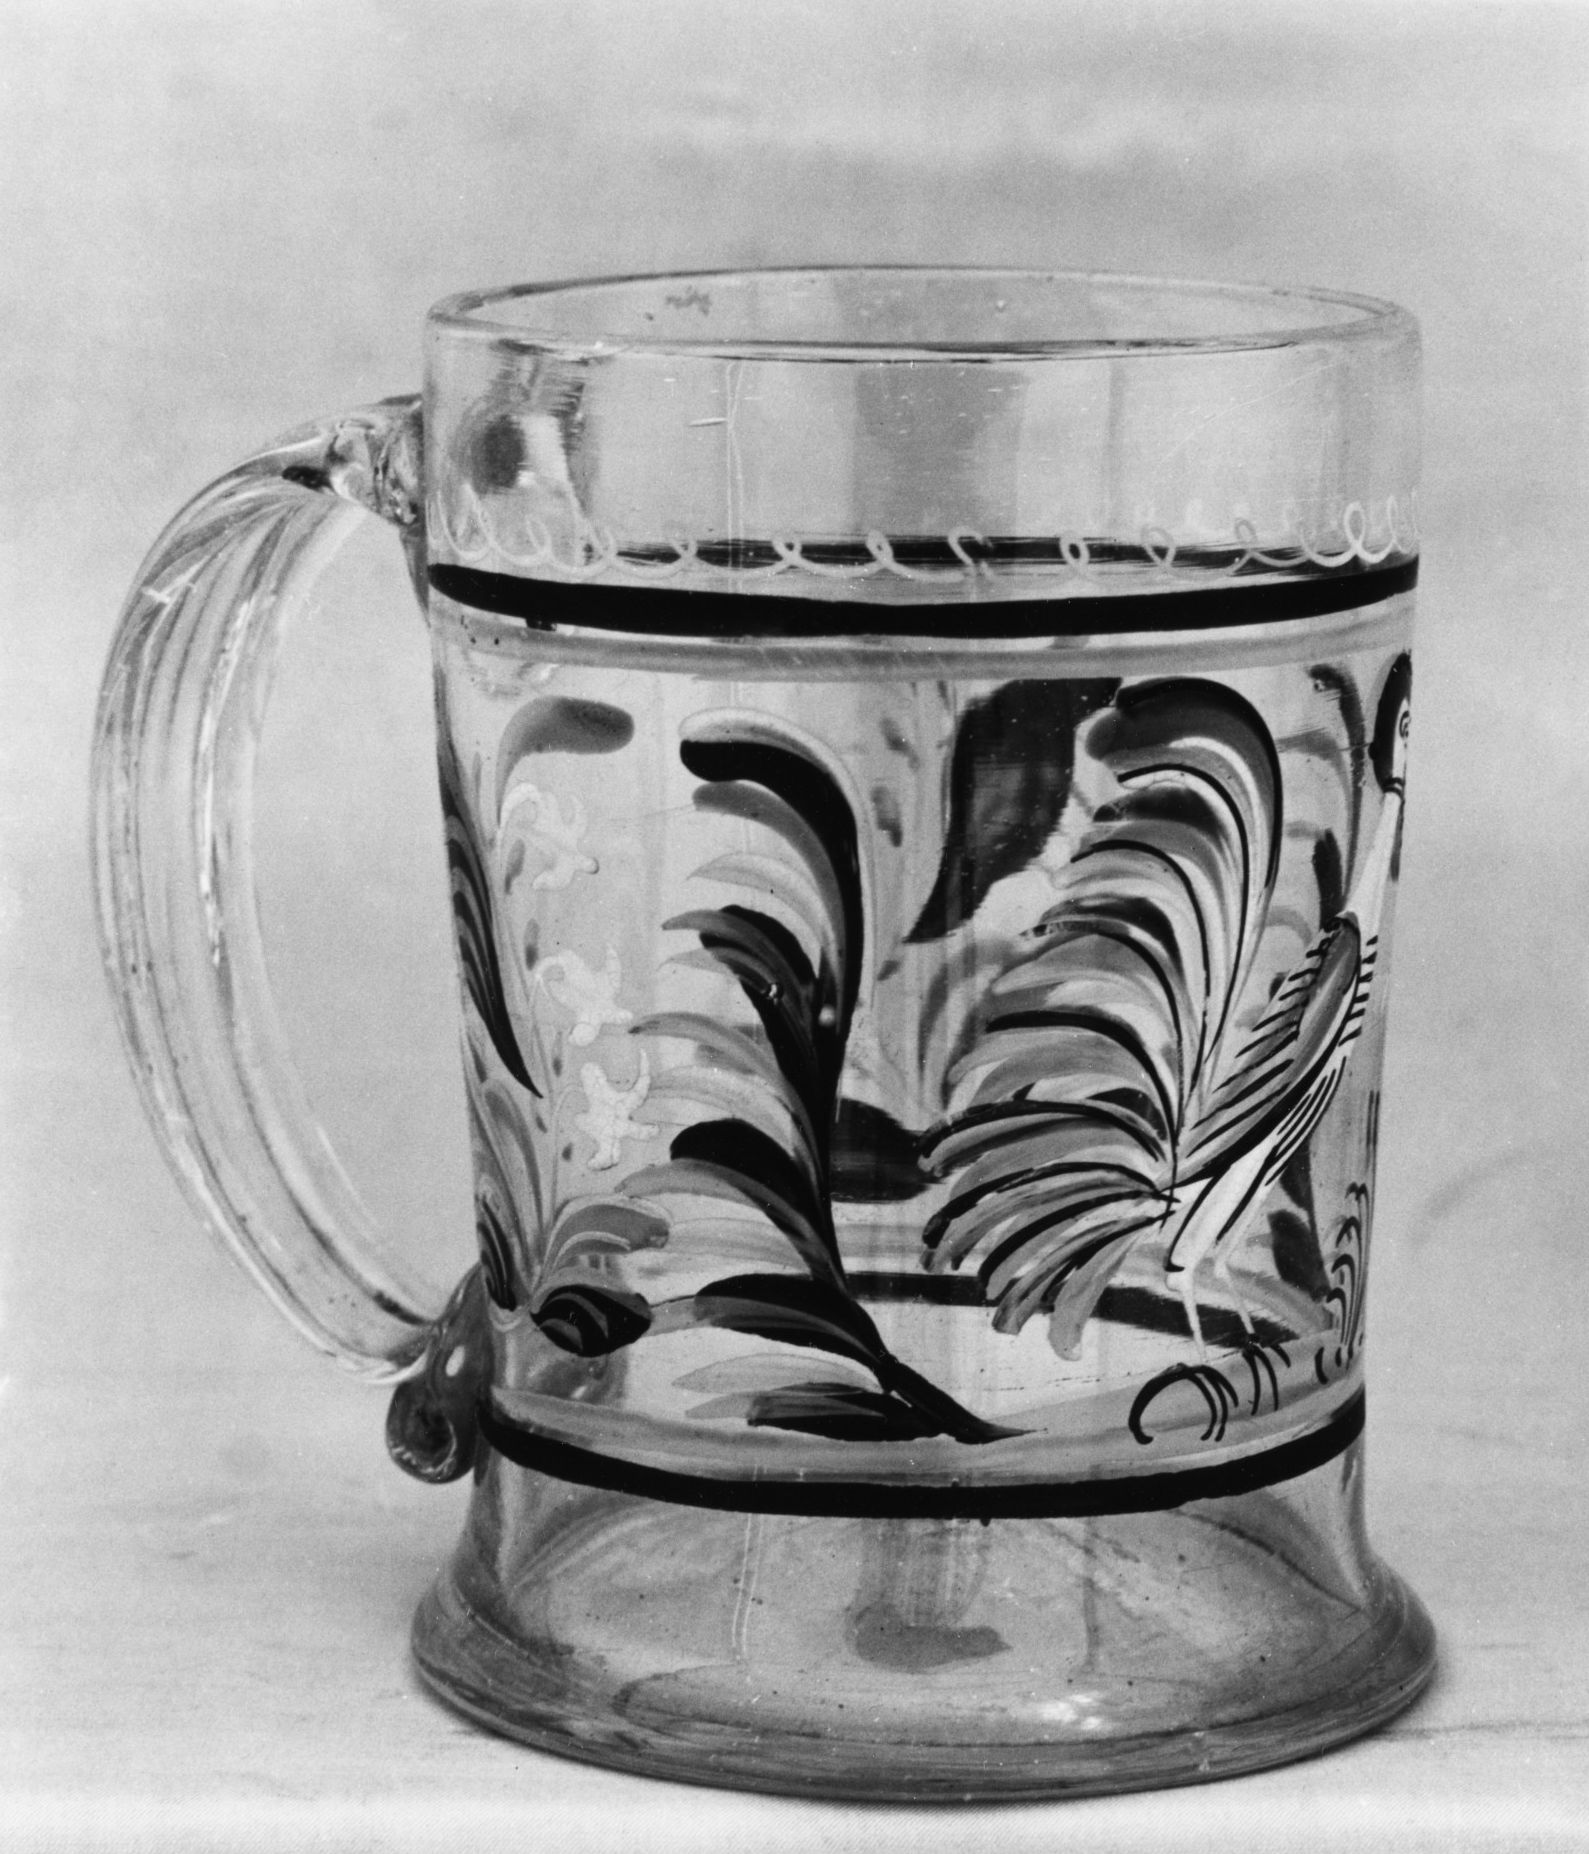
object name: mug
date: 1701-1800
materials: enamel, glass, lead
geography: czech republic